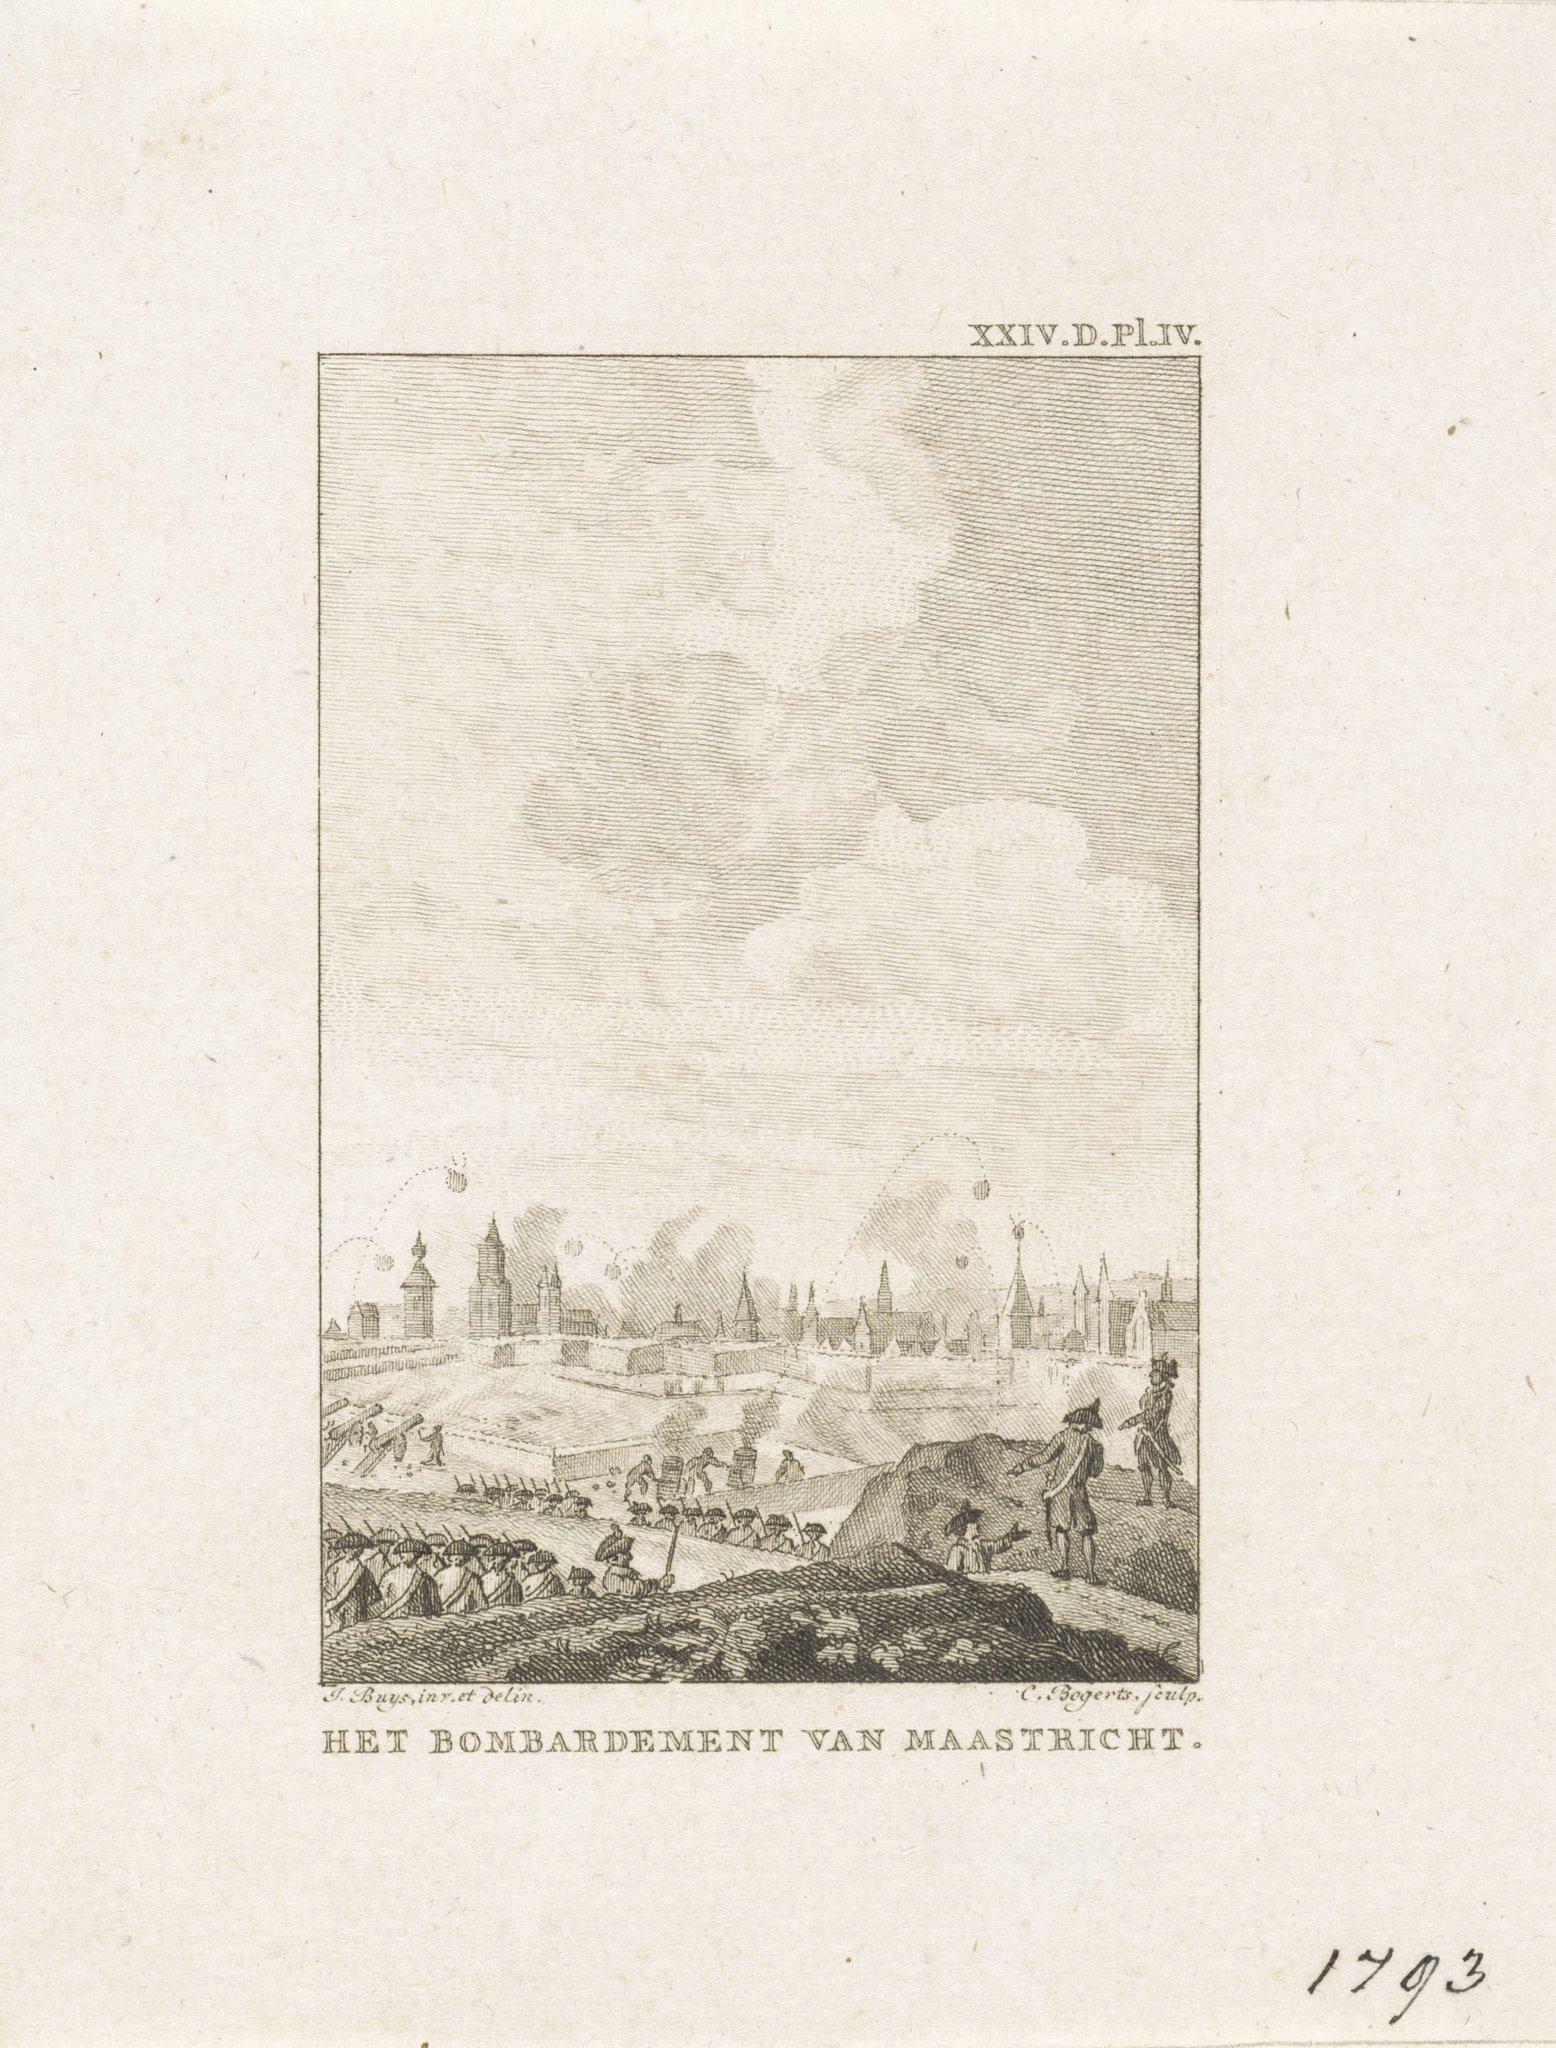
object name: print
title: Het bombardement van Maastricht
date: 1793-1795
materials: paper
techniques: engraving, etching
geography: northern netherlands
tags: bombardment ~ siege, maastricht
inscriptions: collector's mark: Lugt 2228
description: Gebruikt als illustratie in: J. Fokke, Geschiedenissen der Vereenigde Nederlanden voor de vaderlandsche jeugd, Johannes Allart, Amsterdam 1783-1795, 25 delen, dl. 24, pl. 4.